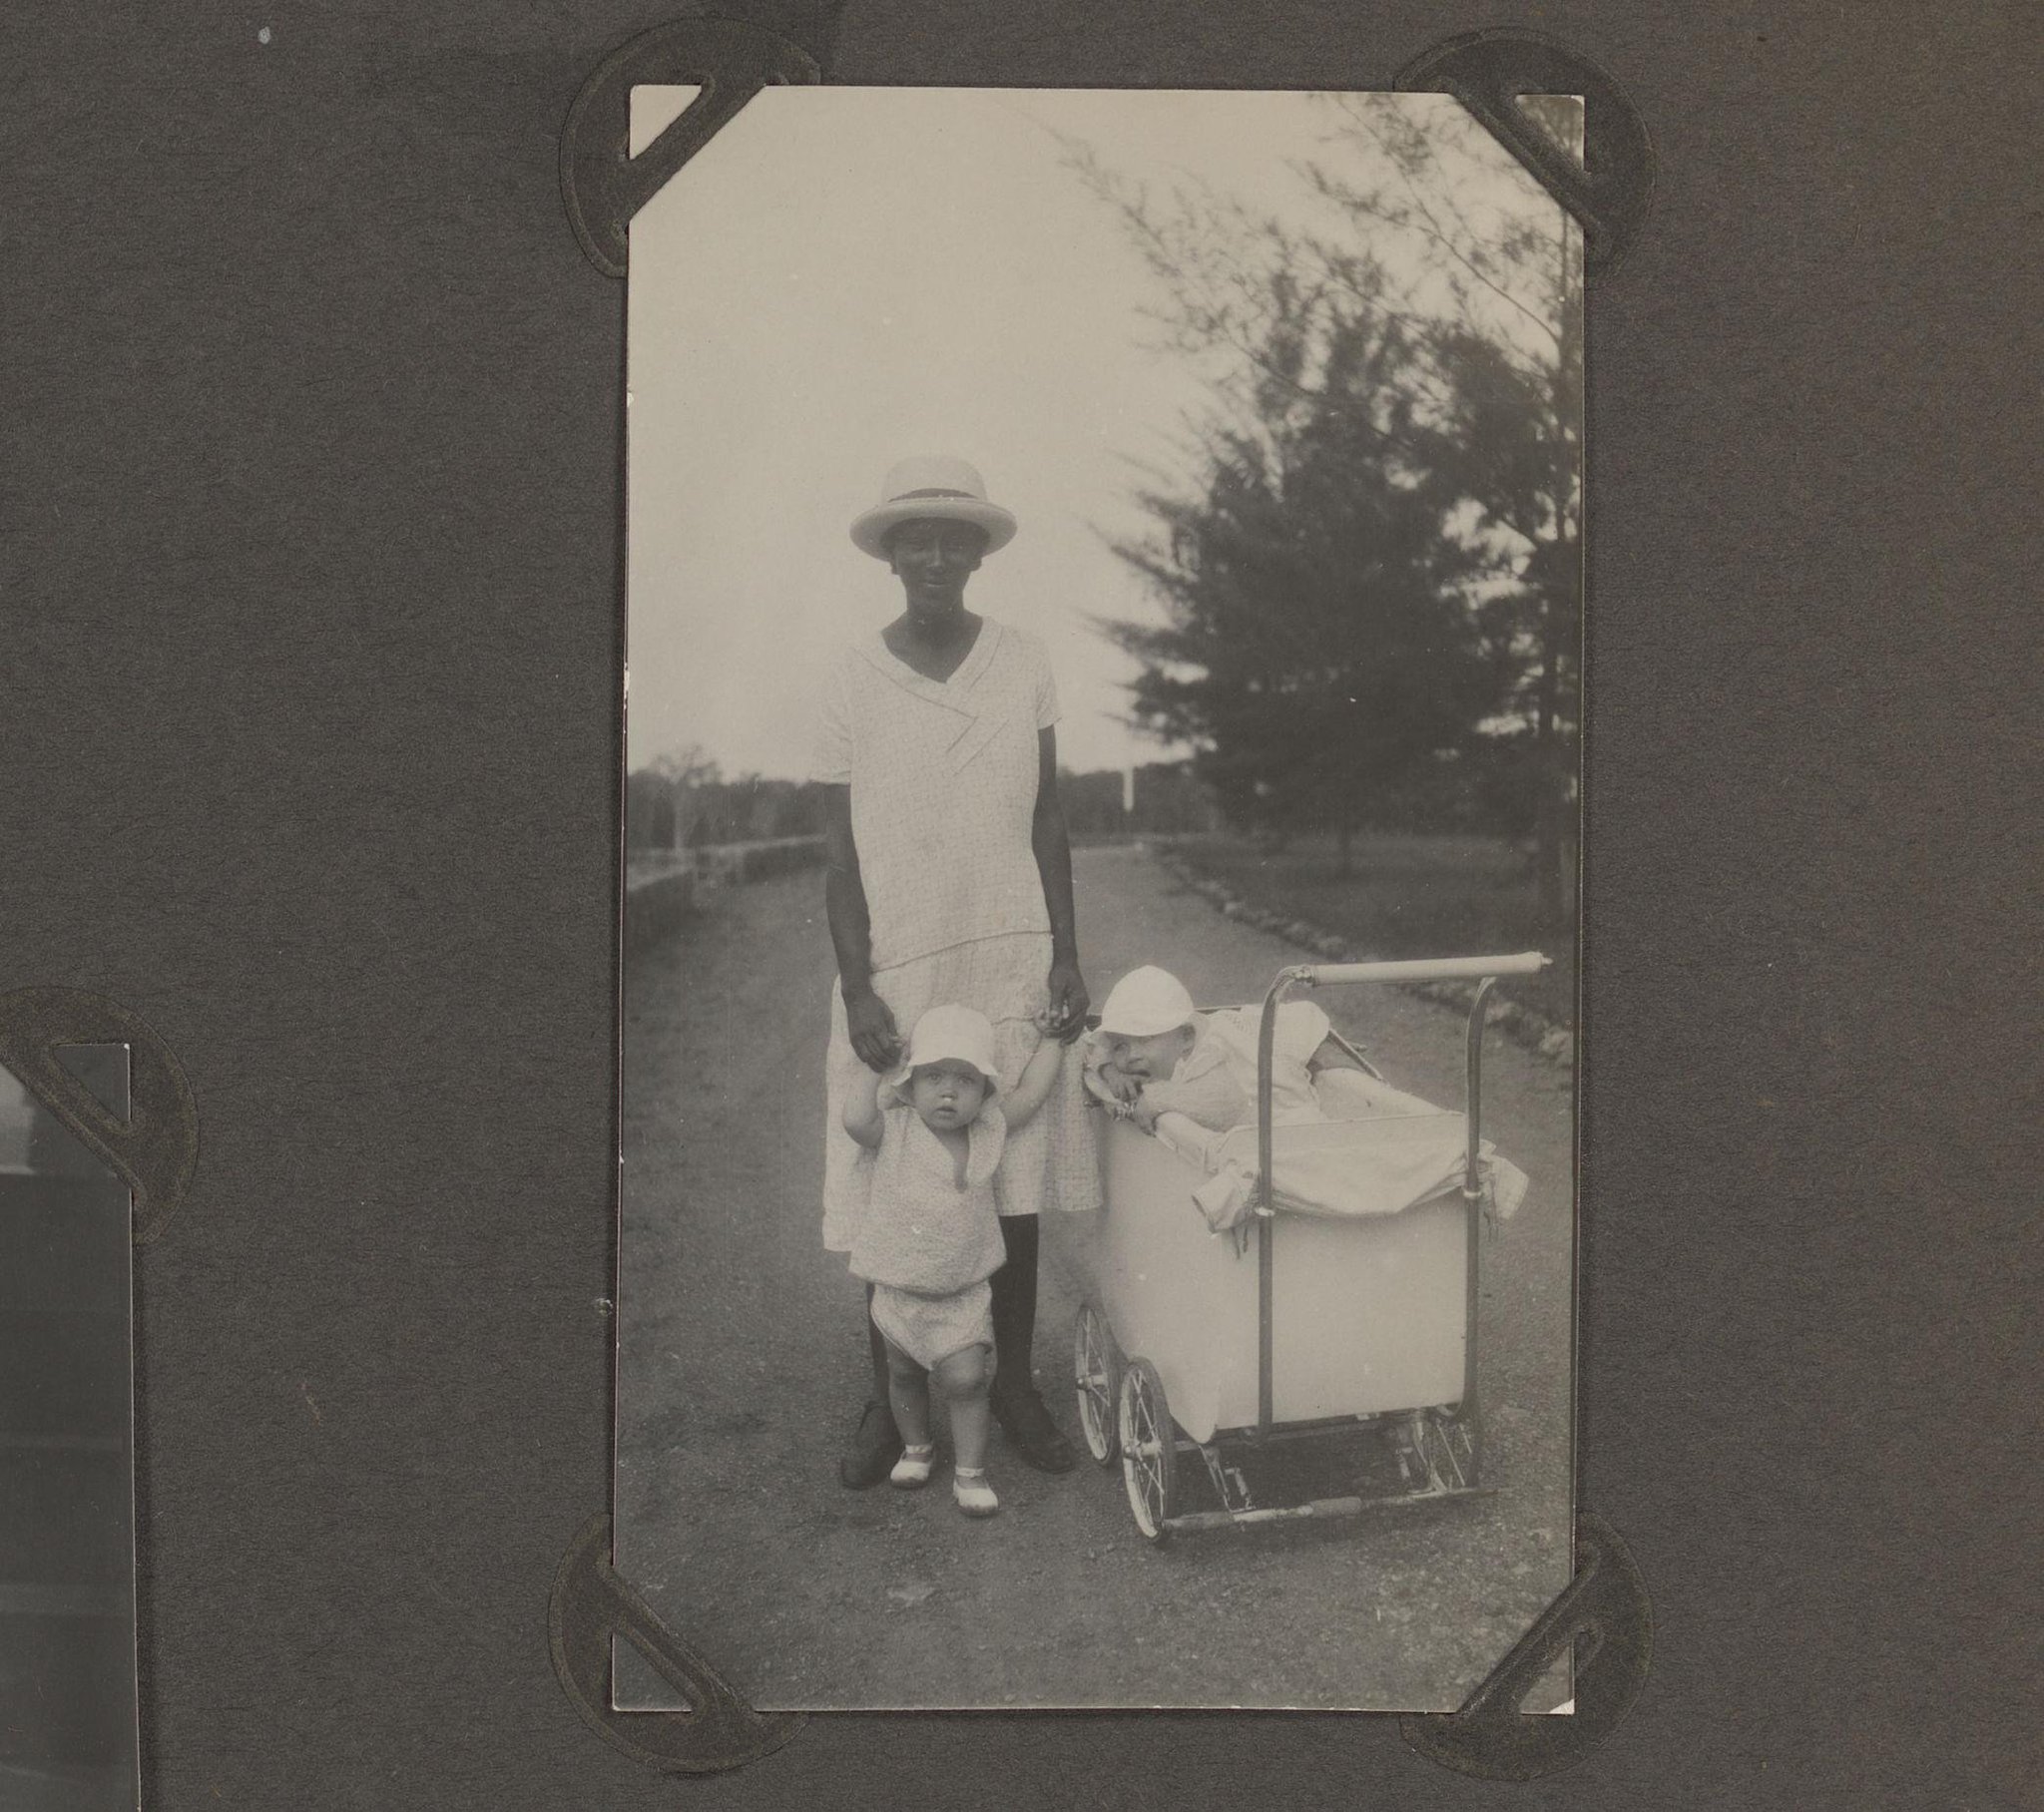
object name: photograph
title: Familiefoto van de kinderen Jetten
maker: Anonymous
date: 1925-1927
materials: photographic support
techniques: photography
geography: suriname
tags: jetten, familie, moengo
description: Familiefoto van de kinderen Jetten. Foto op een bladzijde van een los albumblad. Onderdeel van het ensemble met foto's van de familie van ingenieur Jetten in de mijnbouwstad Moengo in Suriname.